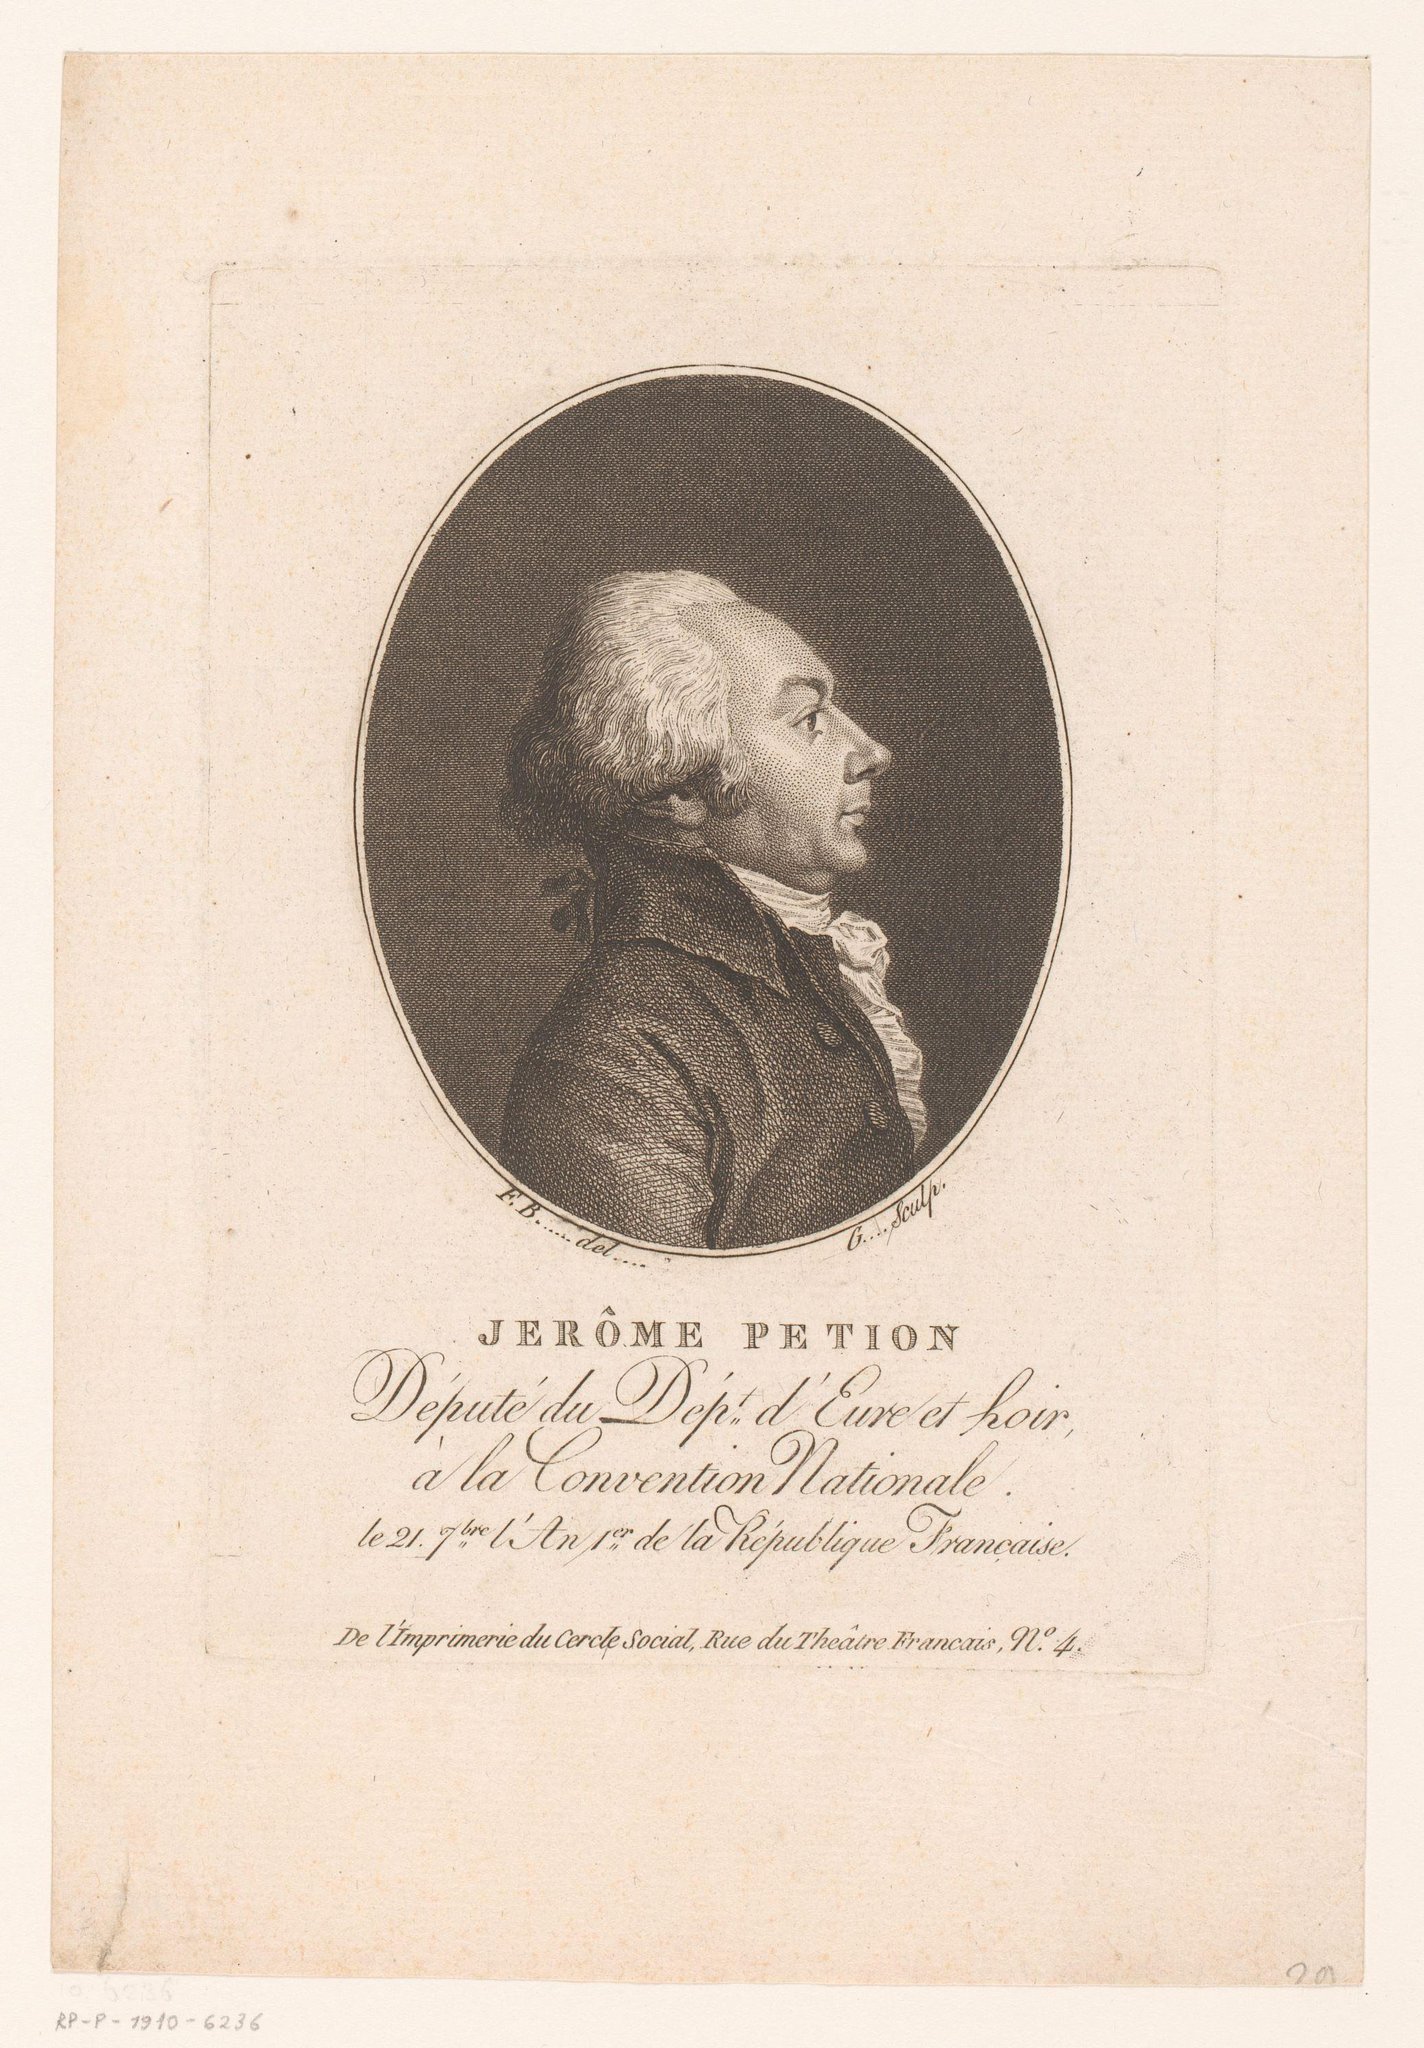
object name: print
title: Portret van Jérôme Pétion de Villeneuve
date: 1786-1825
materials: paper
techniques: engraving, etching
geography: france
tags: politician, ornament ~ medallion, historical persons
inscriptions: collector's mark: Lugt 2228